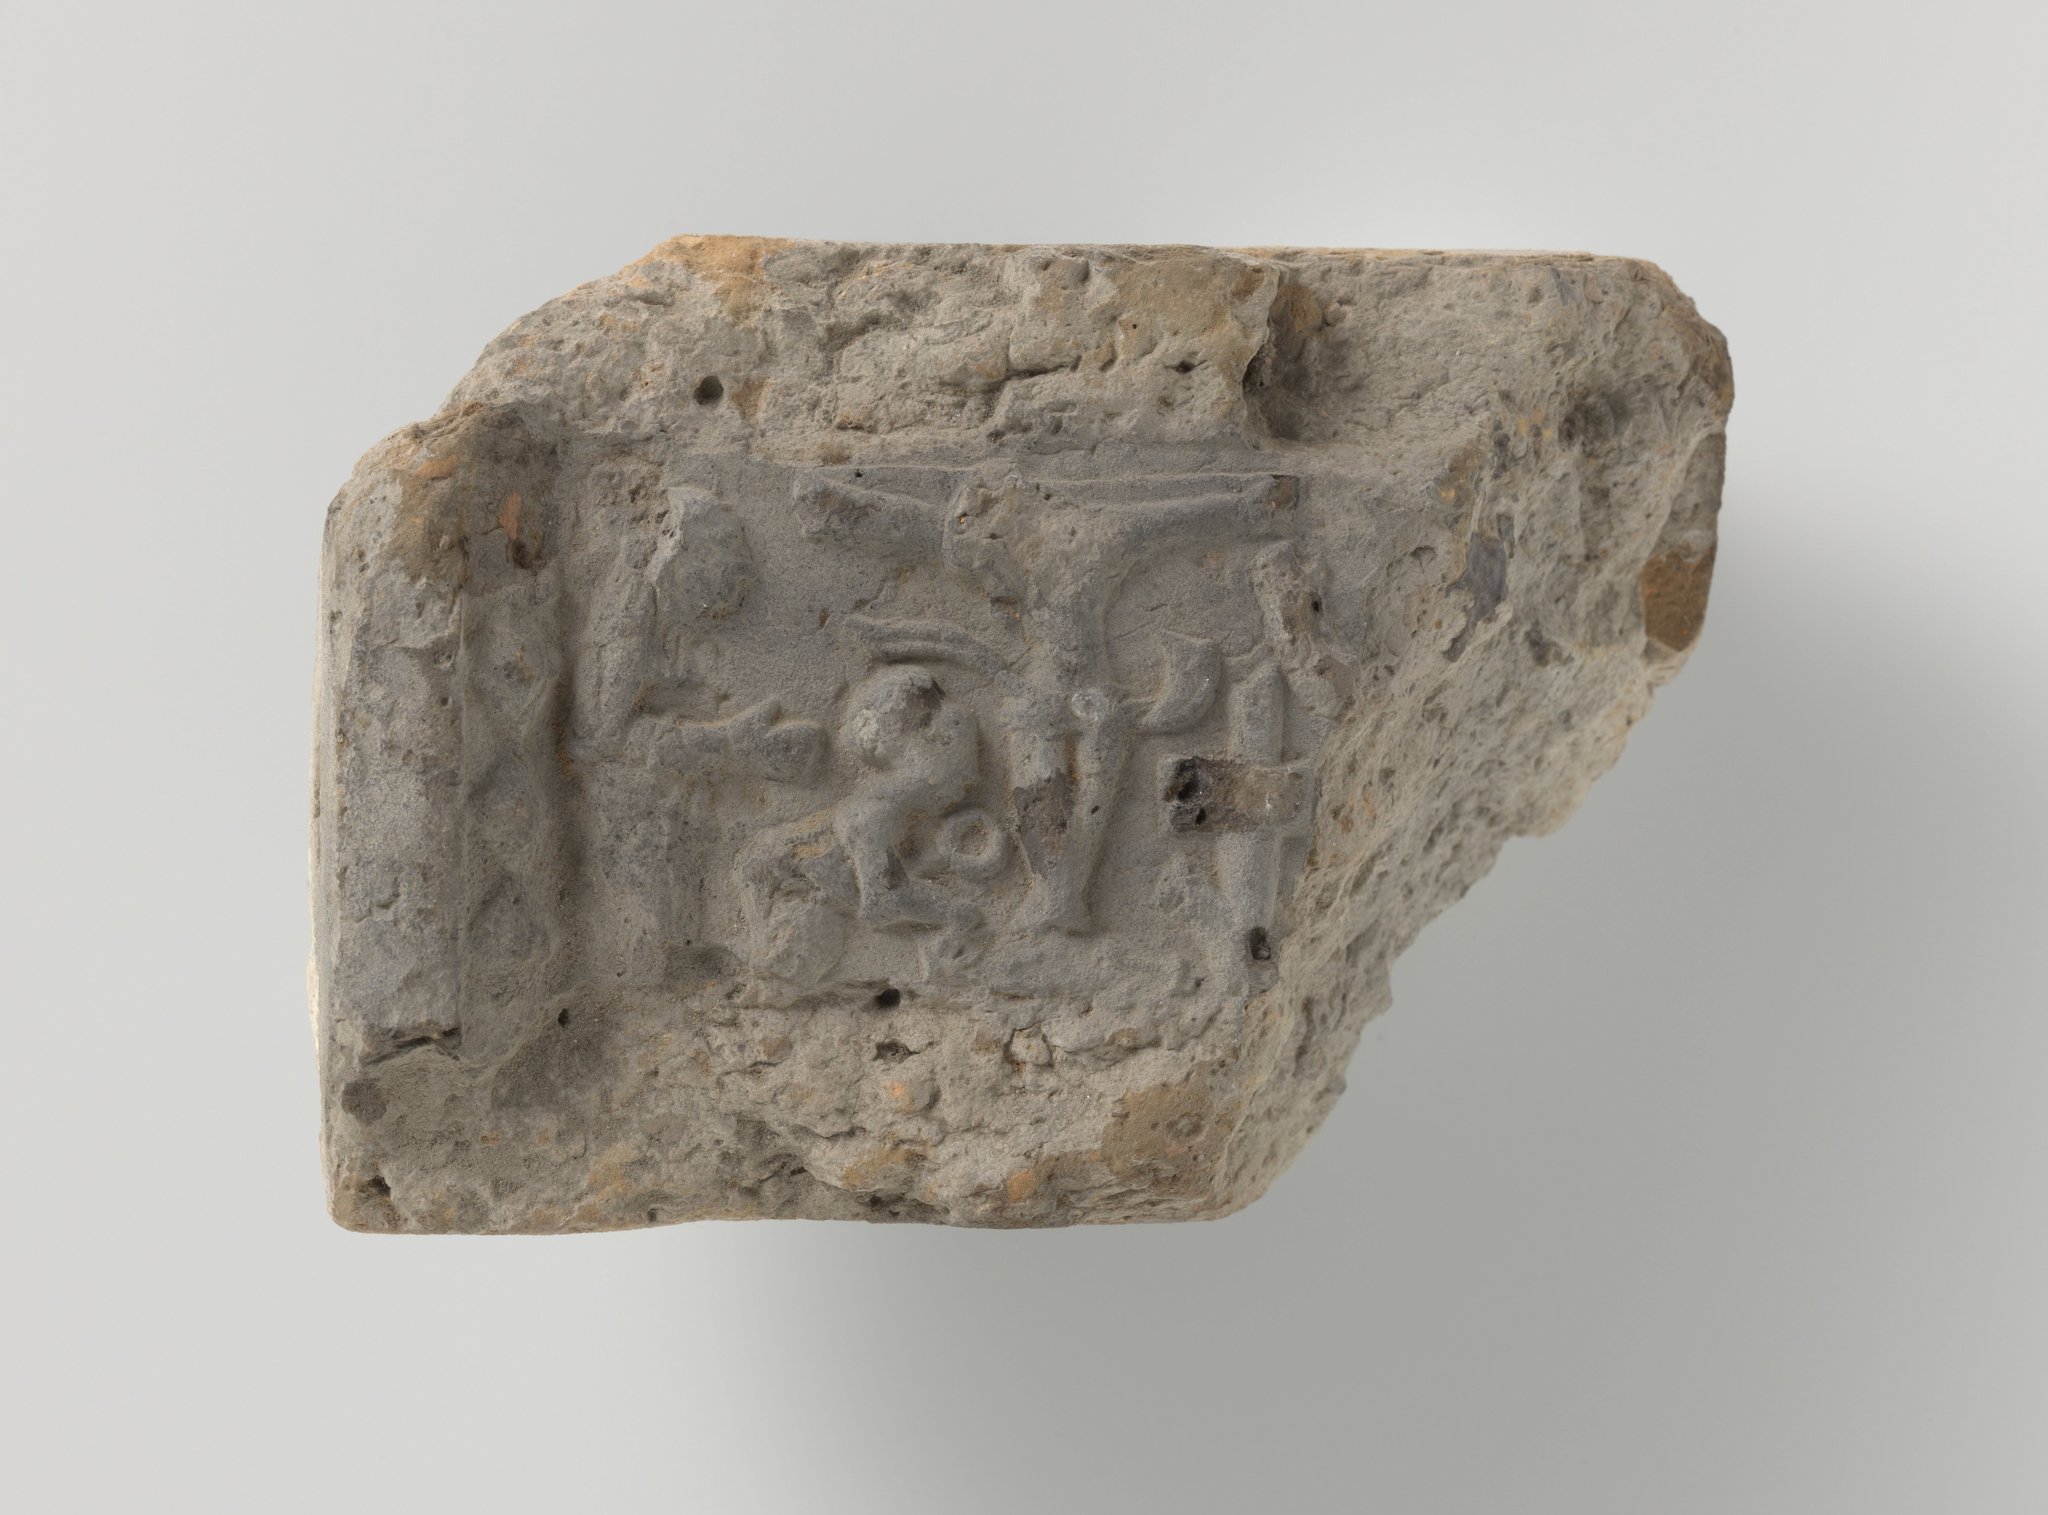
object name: hearthstone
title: Haardsteen met voorstelling van Christus aan het kruis met de drie Maria's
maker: Anonymous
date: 1525-1550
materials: earthenware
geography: southern netherlands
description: Haardsteen met voorstelling van Christus aan het kruis met de drie Maria's. Beschadigd; rechterbenedenhoek en linkerbovenhoek ontbreken.